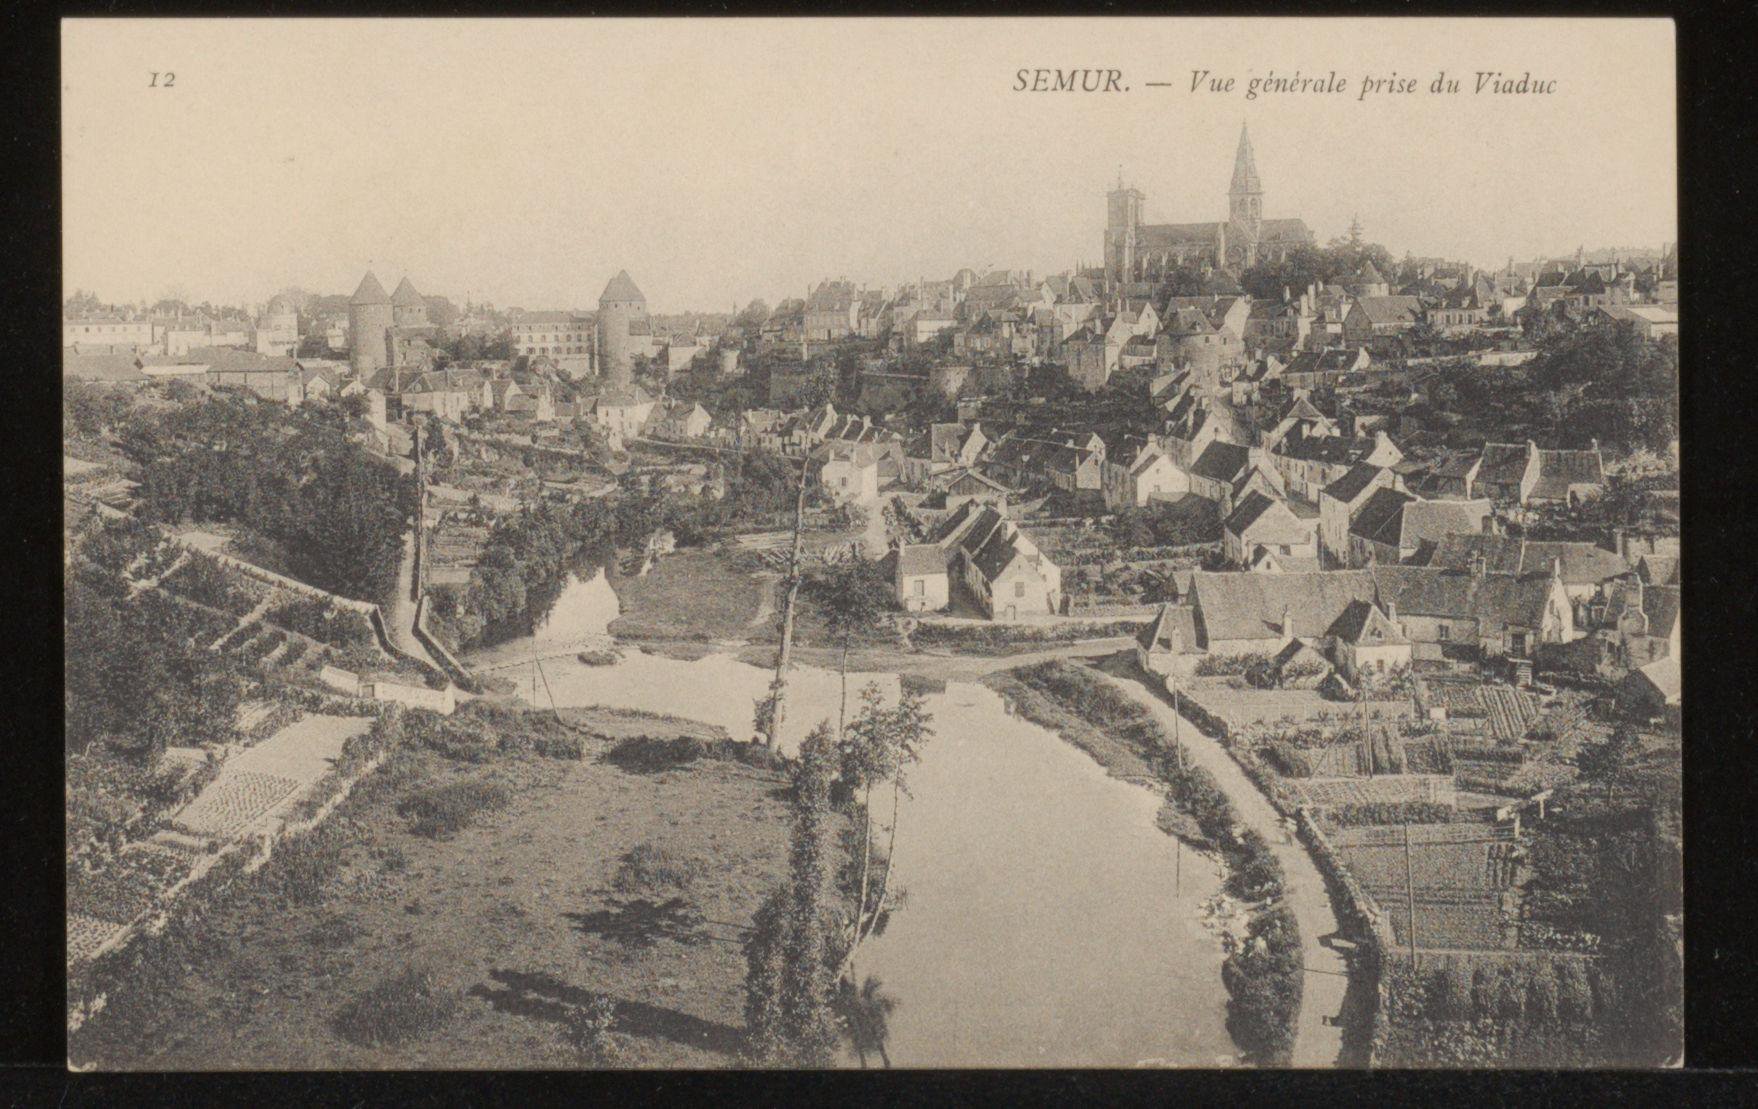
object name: ansichtkaart, prentbriefkaart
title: Prentbriefkaart aan Andries Bonger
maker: Anonymous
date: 1871-1936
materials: cardboard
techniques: photograph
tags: andries bonger